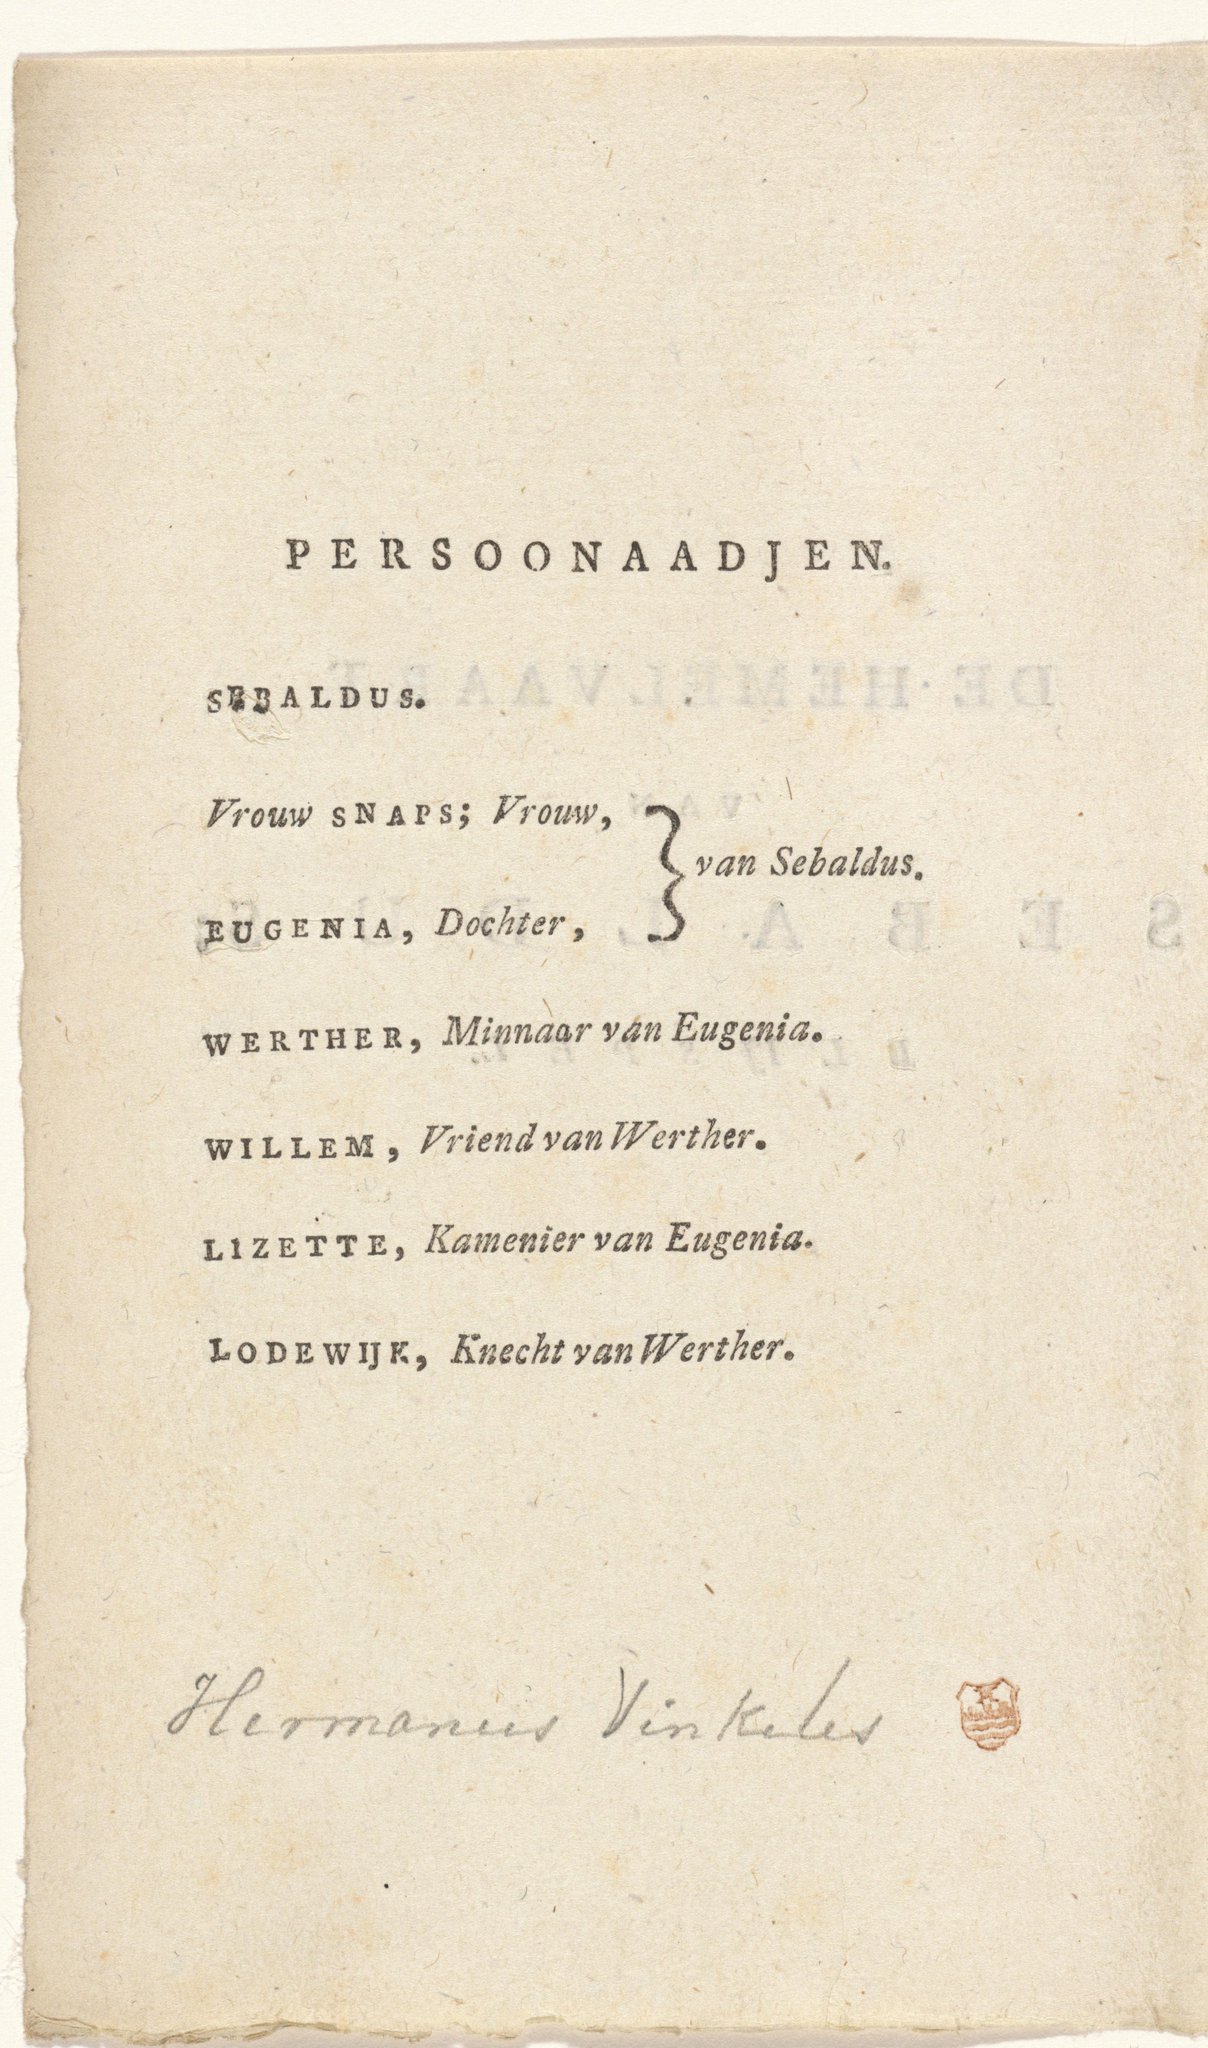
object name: titelblad, titelpagina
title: Titelpagina voor: 'De Hemelvaart van Sebaldus', 1786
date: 1786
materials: paper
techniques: letterpress printing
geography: amsterdam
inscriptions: collector's mark: Lugt 2760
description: Deze prent is ook gebruikt als titelpagina in: Nomsz, Johannes. De Nederlandsche dichtkundige schouwburg. Amsterdam: Jan Barend Elwe en Dirk Meland Langeveld, 1786-1791.